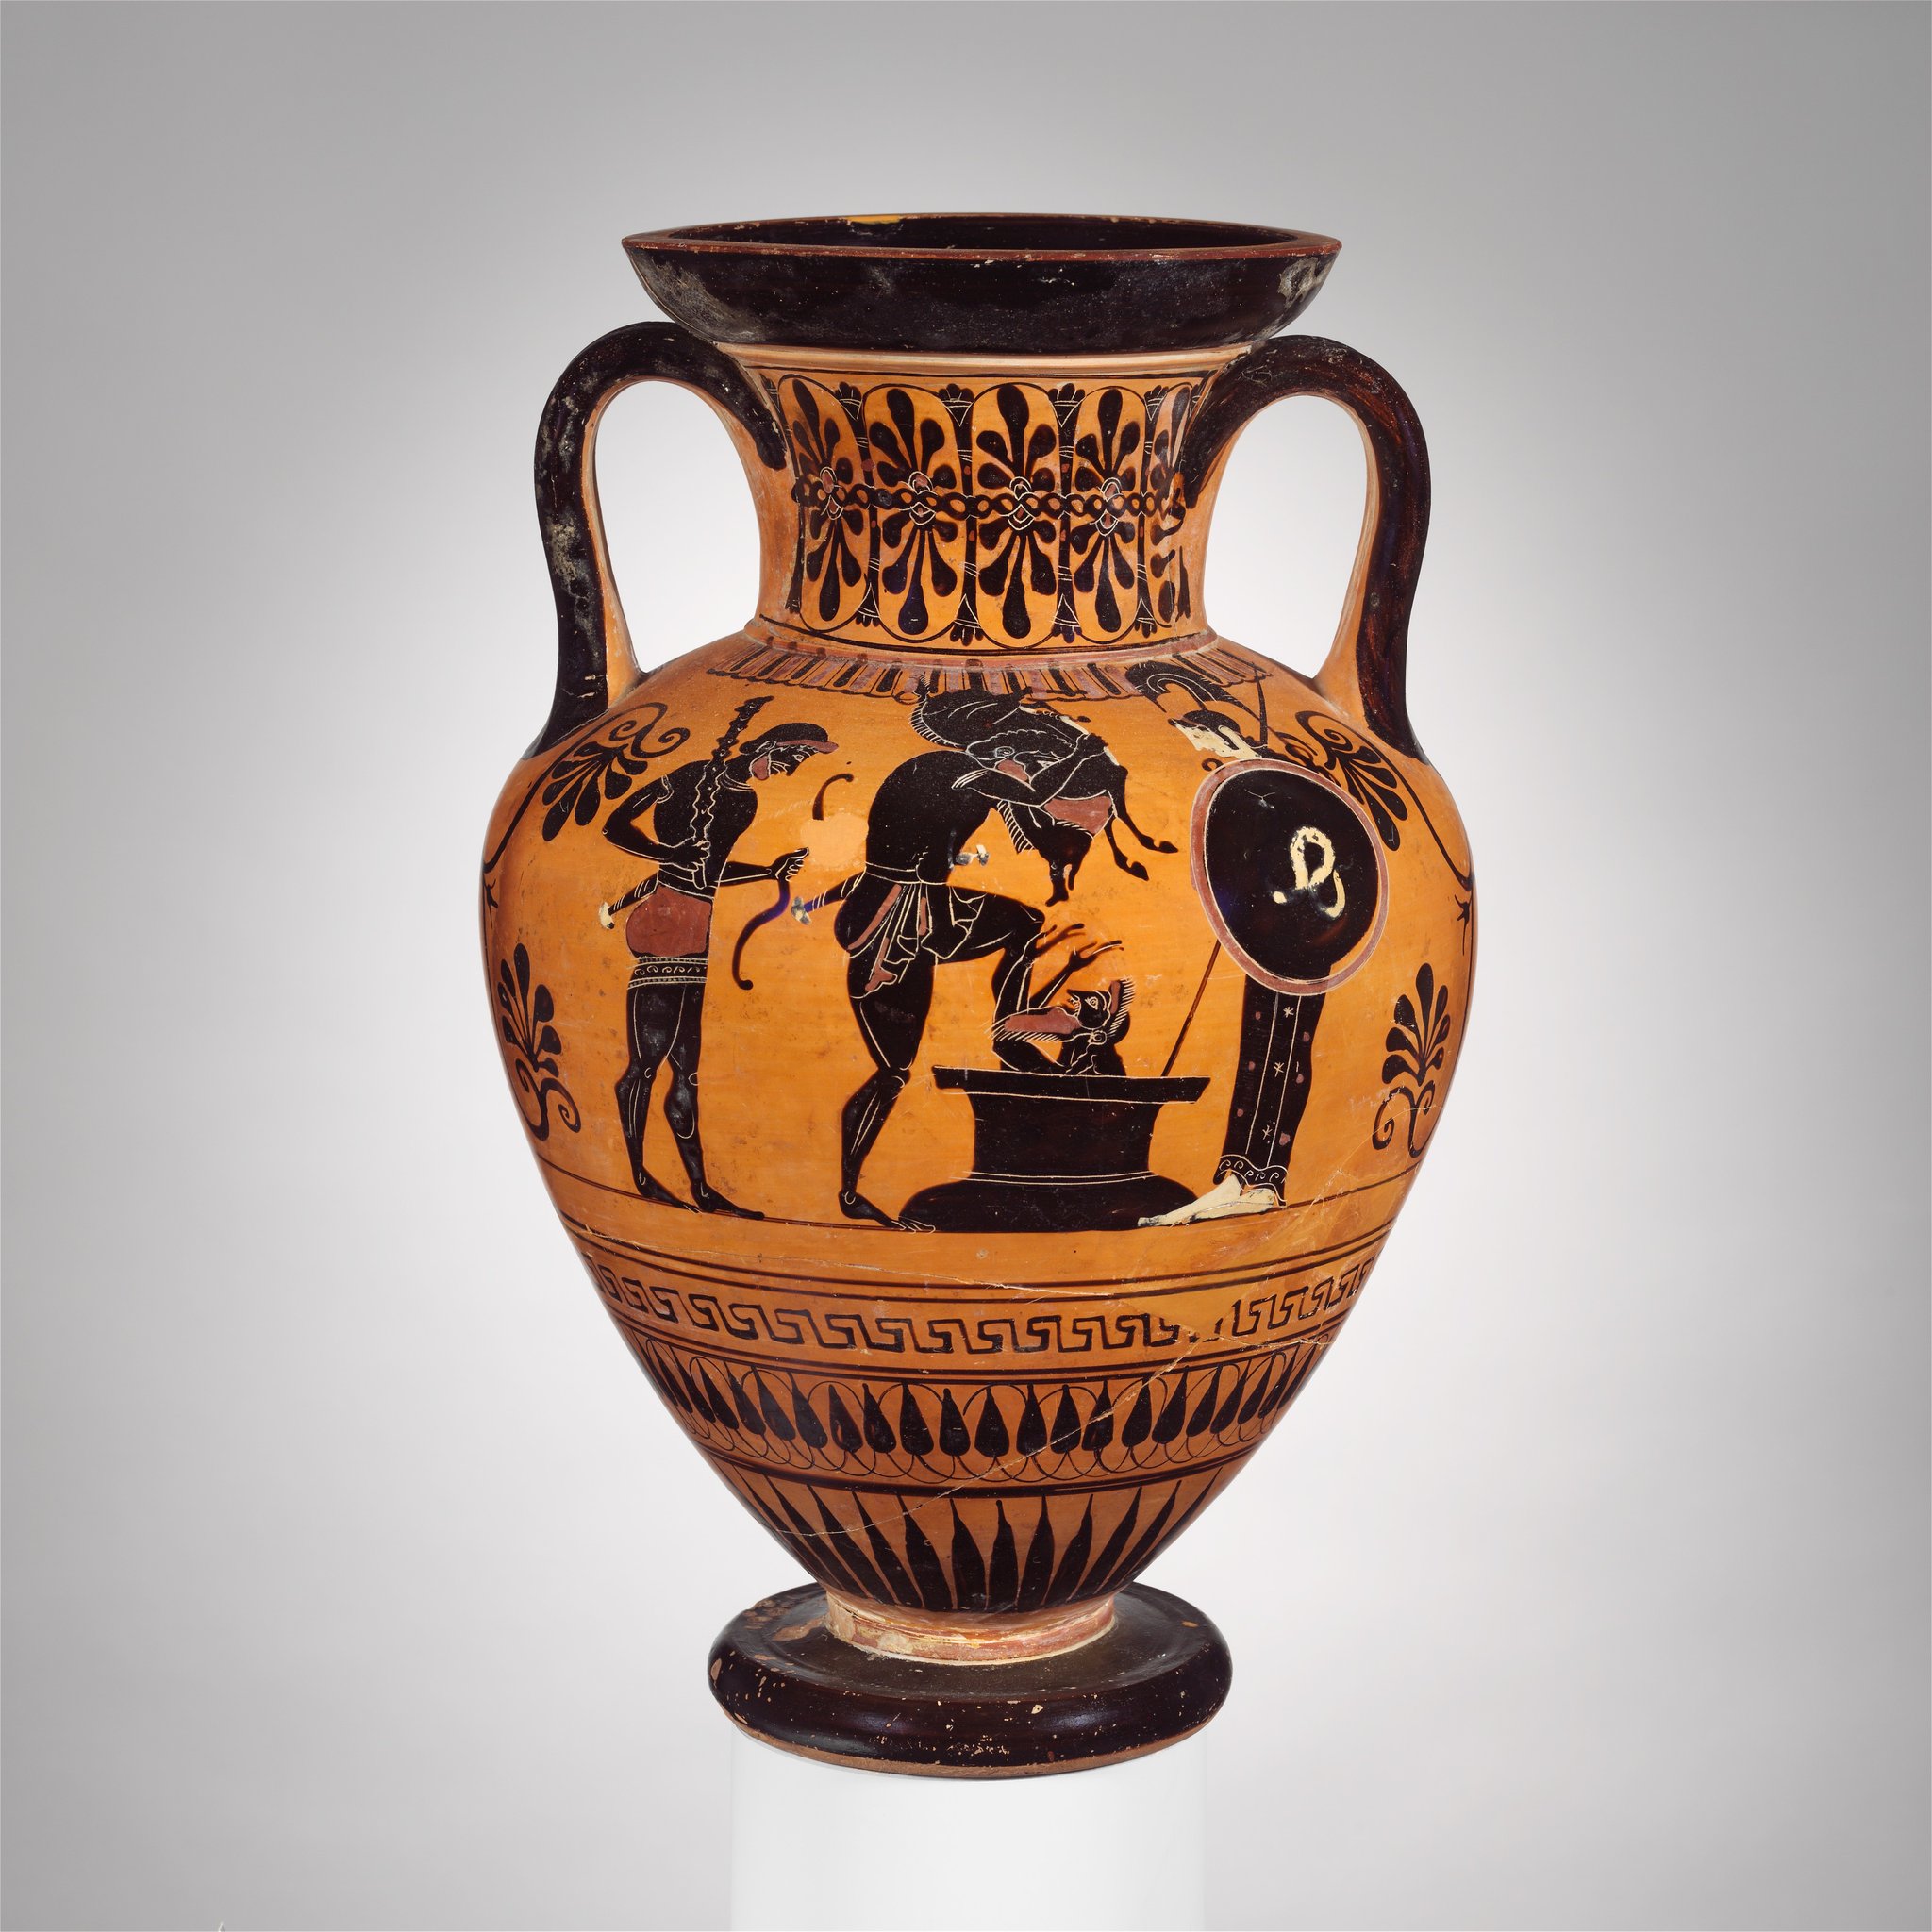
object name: amphora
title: Terracotta neck-amphora (jar)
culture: greek, attic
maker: group of toronto 305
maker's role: artist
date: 525-501 BCE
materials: terracotta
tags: men,boars,horses,herakles